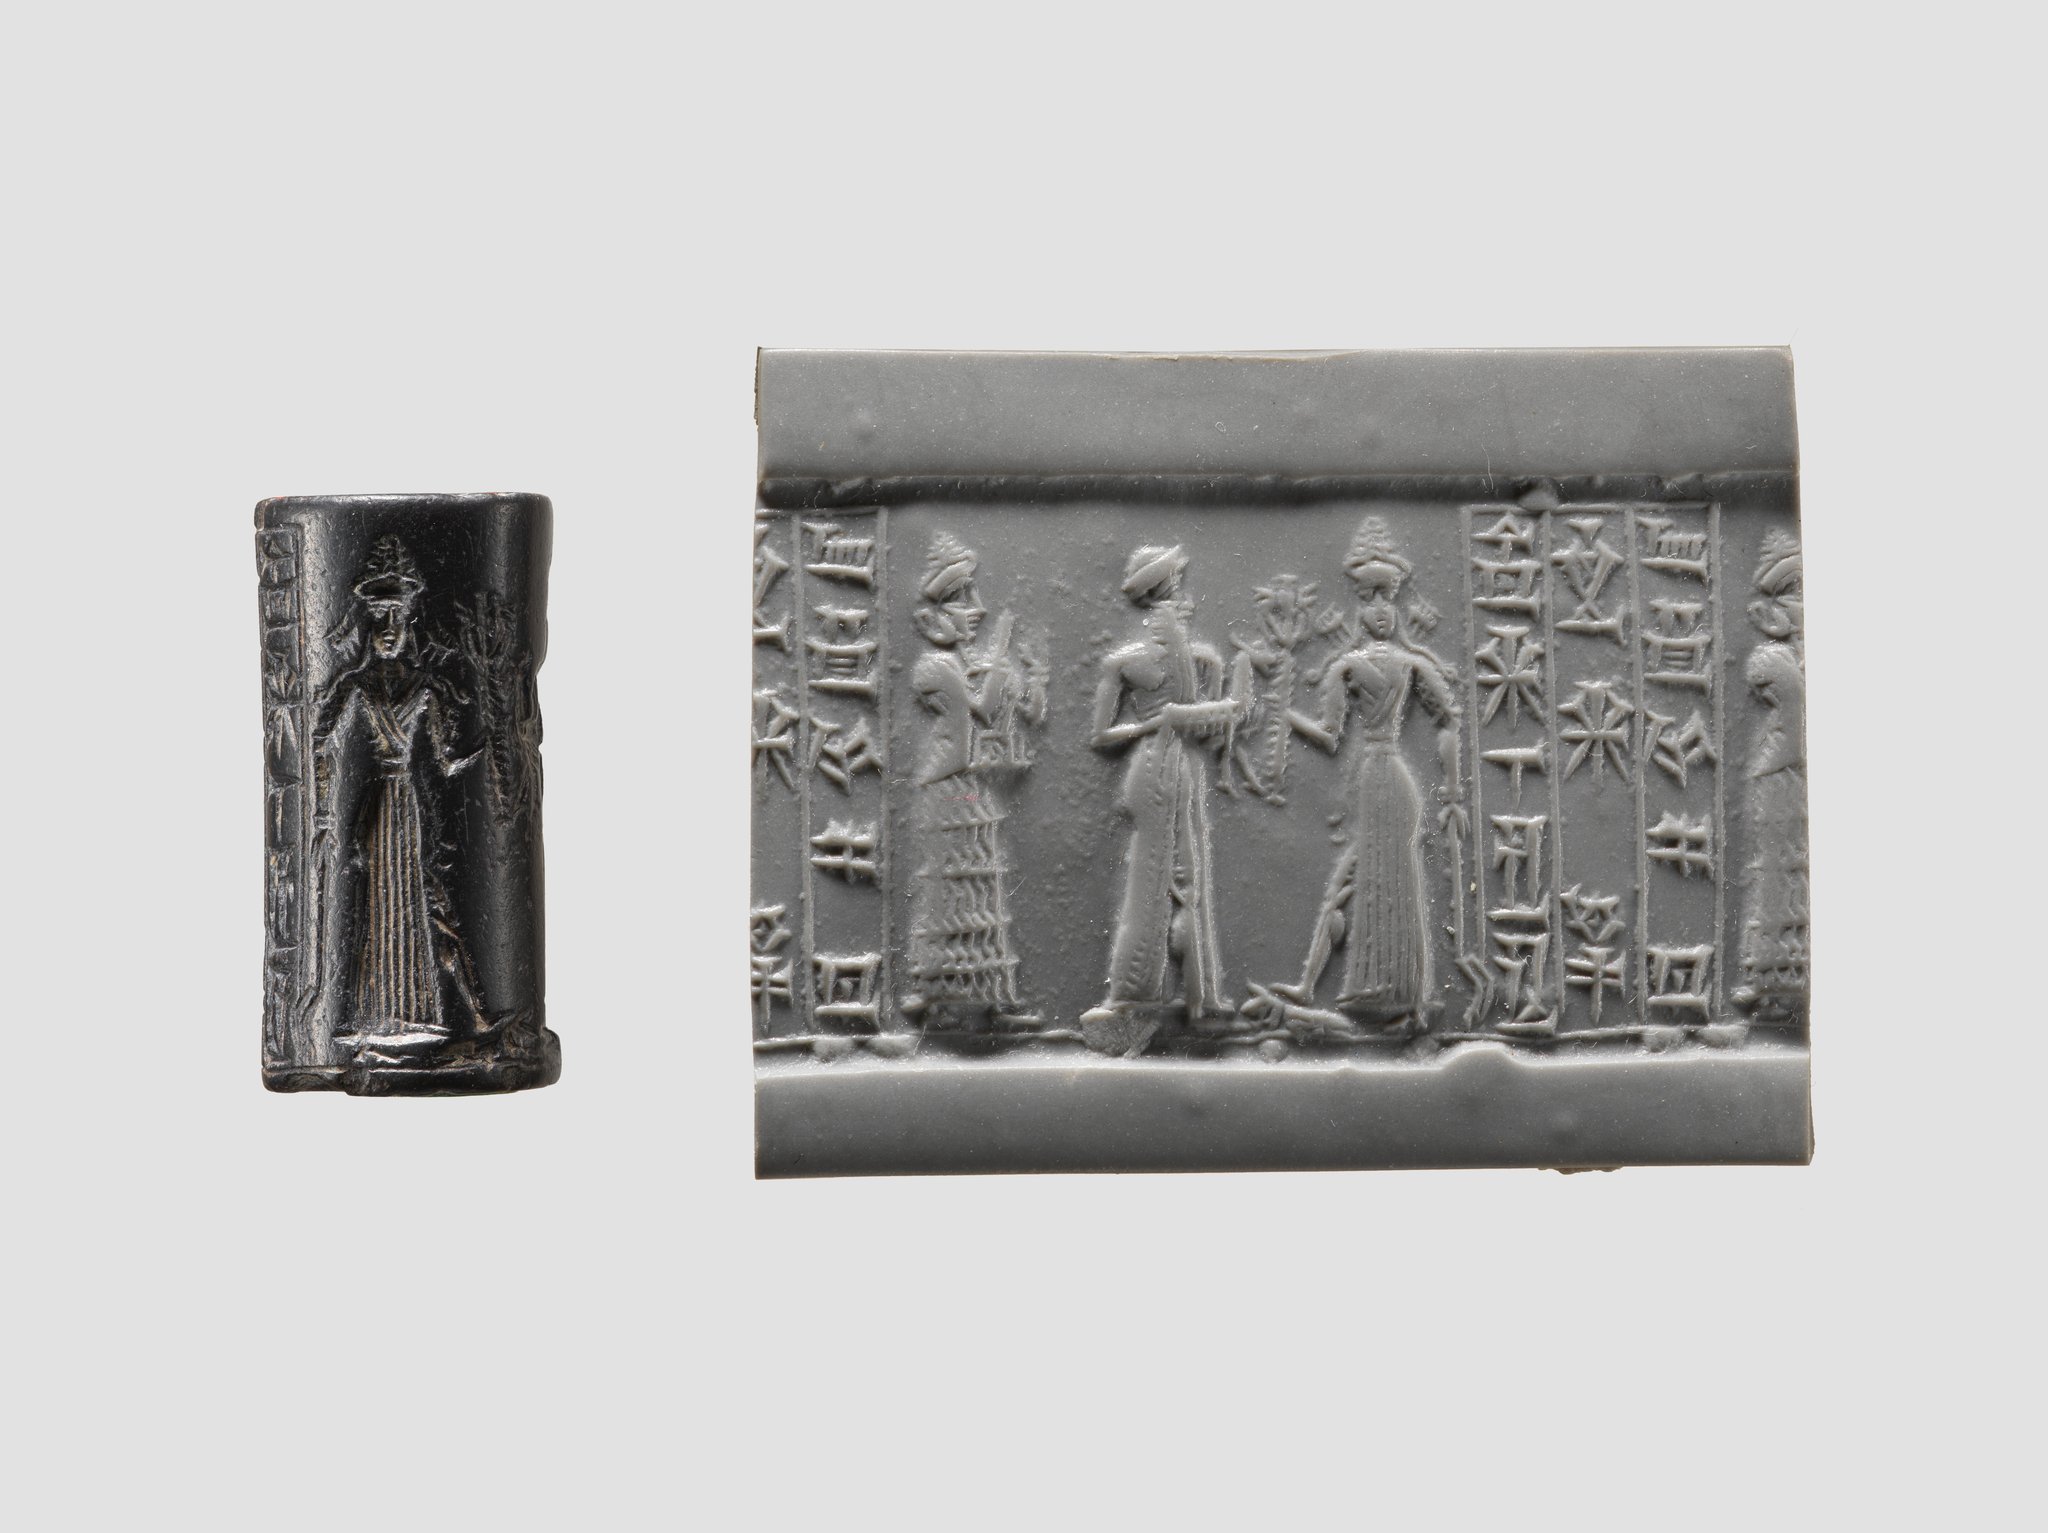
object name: cylinder seal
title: Cylinder seal and modern impression: suppliant goddess and offering bearer approaching Ishtar, three columns of inscription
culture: babylonian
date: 2000-1668 BCE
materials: mineral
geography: mesopotamia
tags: men,goddess